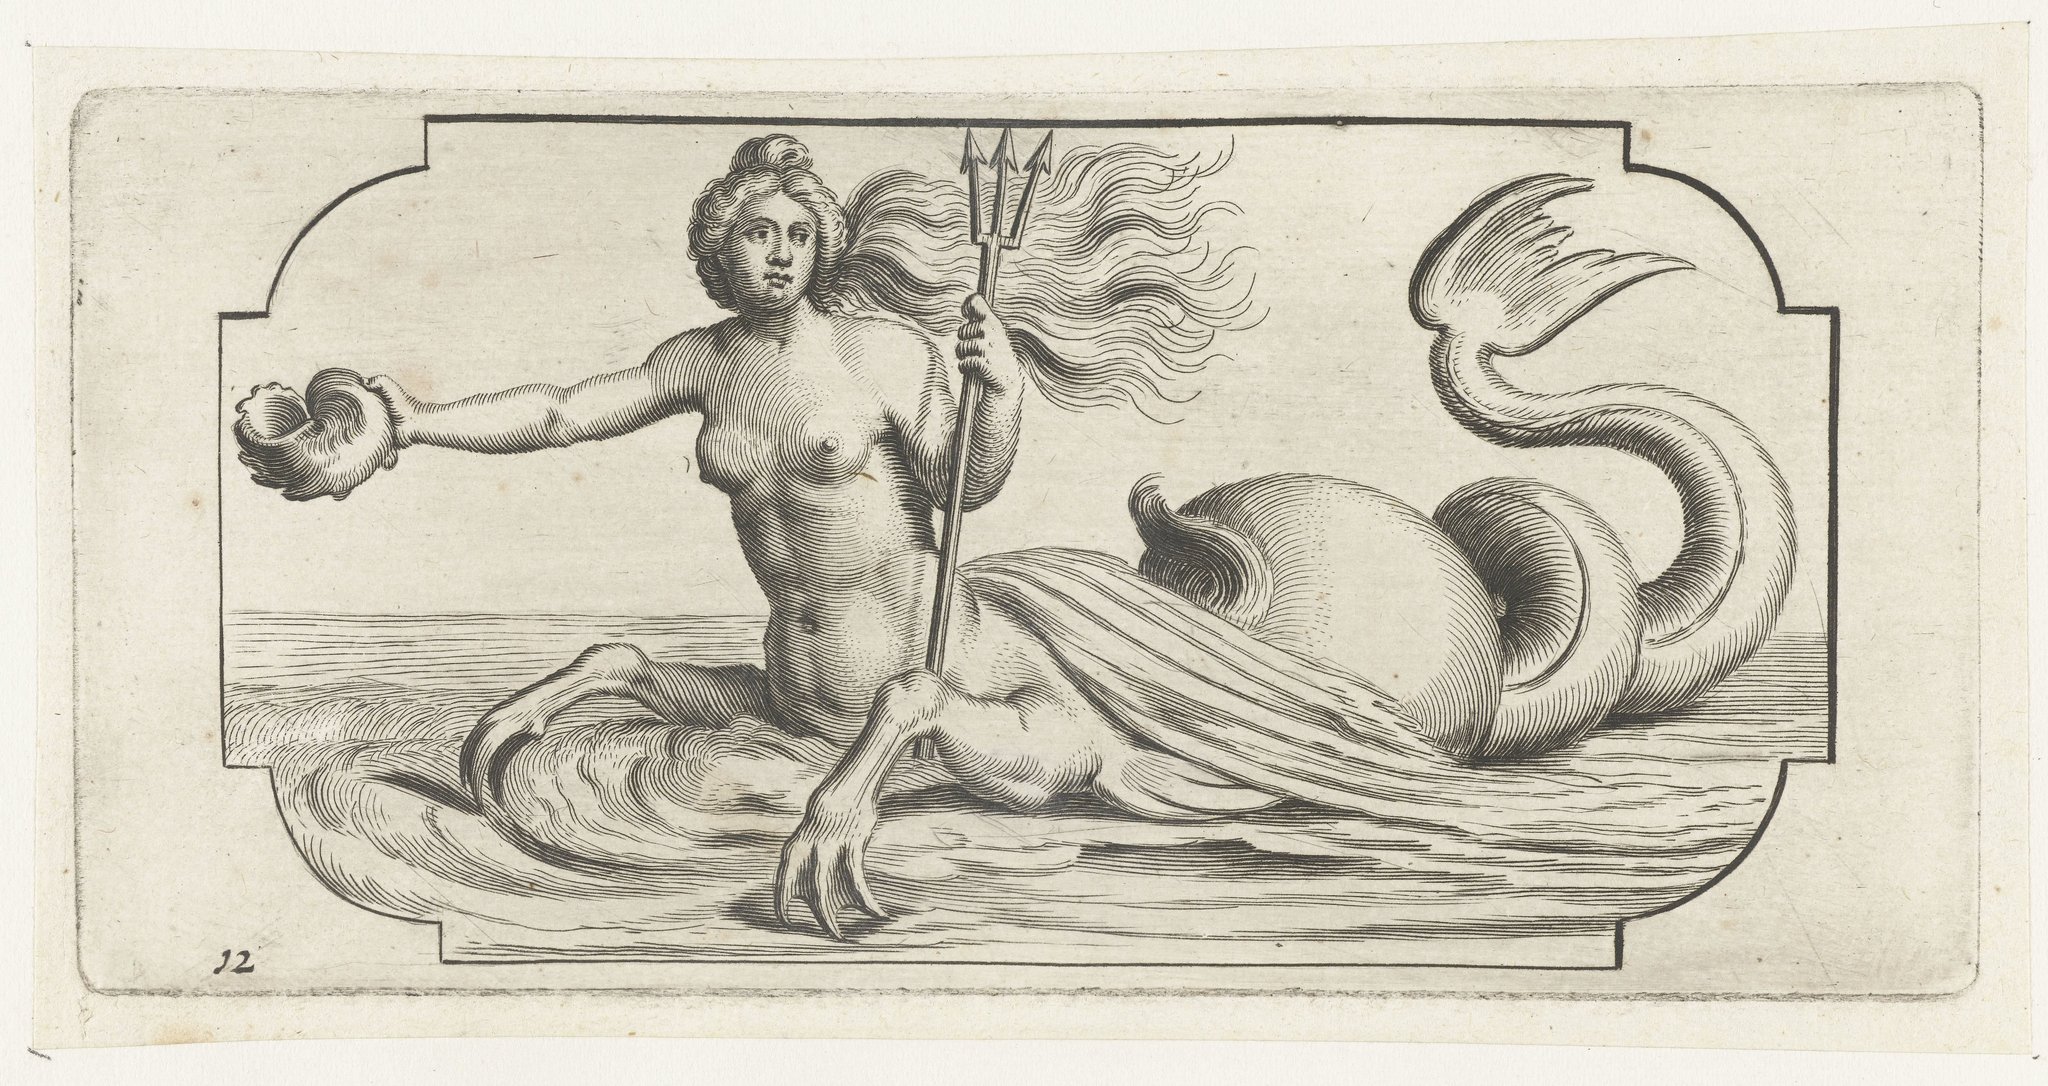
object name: ornament print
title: Nouveau Livre des Dieux et Deeßes De la Marine Bouckje van Zeegoden en Godinnen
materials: paper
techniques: engraving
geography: amsterdam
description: Een vrouwenfiguur houdt een Neptunusstaf en een schelp in de hand.